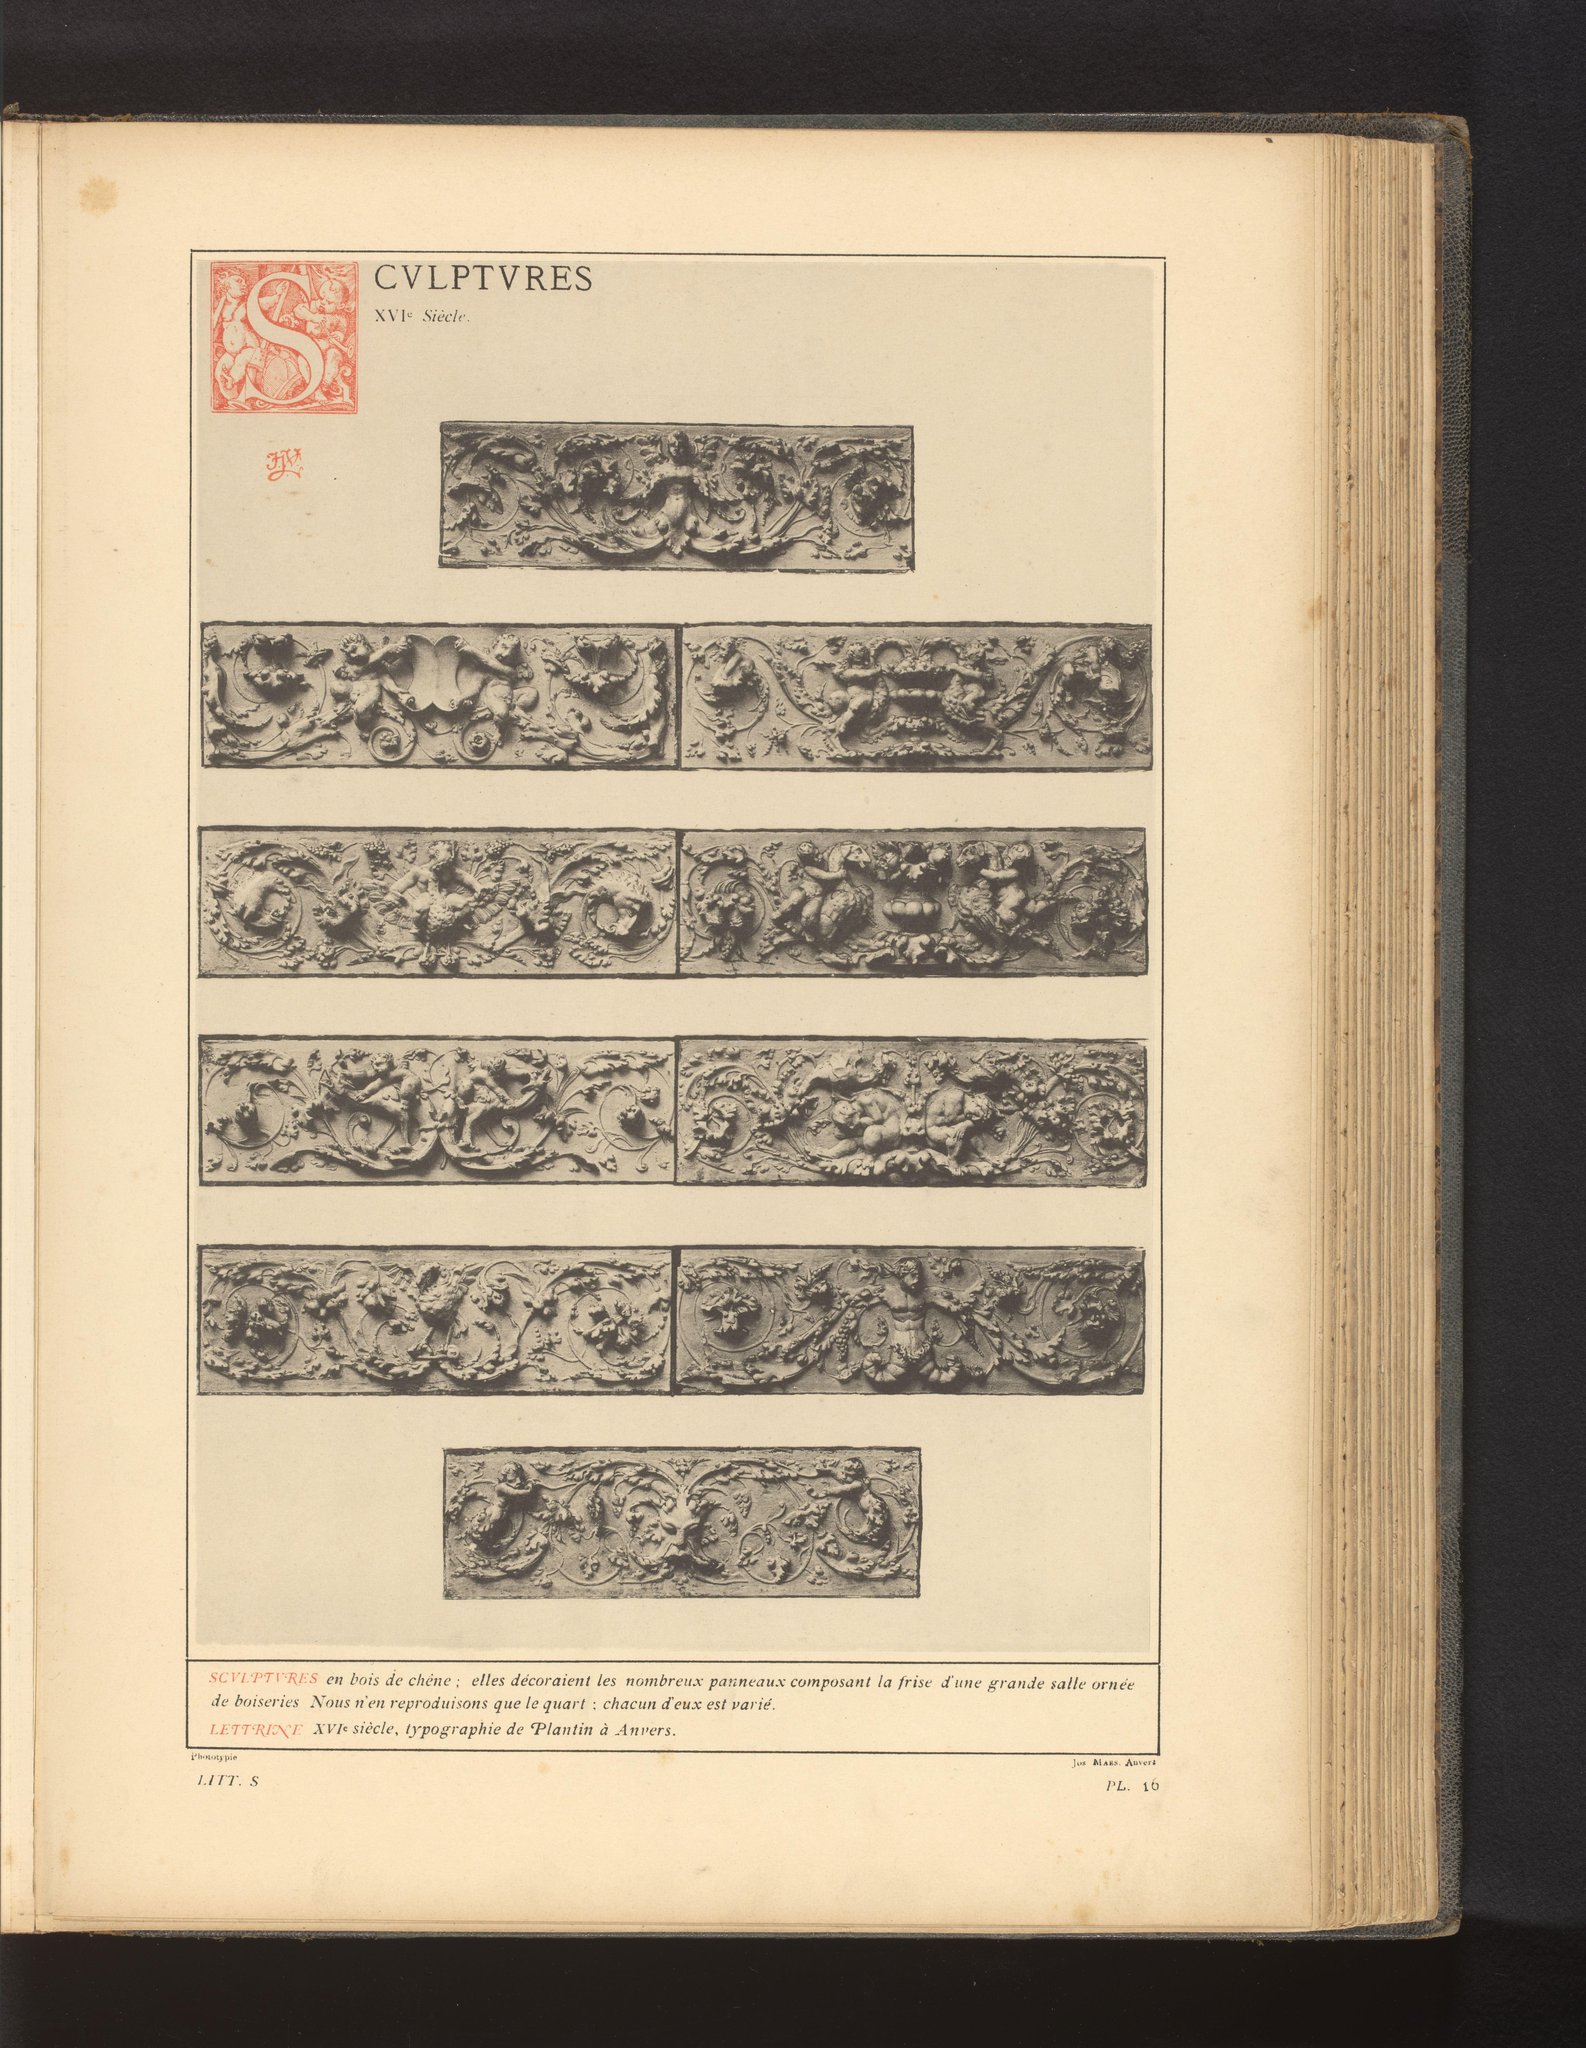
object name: photomechanical print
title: Gedecoreerde friezen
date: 1876-1881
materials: paper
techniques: photograph, photolithography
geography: antwerp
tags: sculpture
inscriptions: monogram: ‘JJvY’, inscription: ‘SCULPTURES en bois de chêne (...)’, inscription: ‘LITT. S. - PL. 16.’